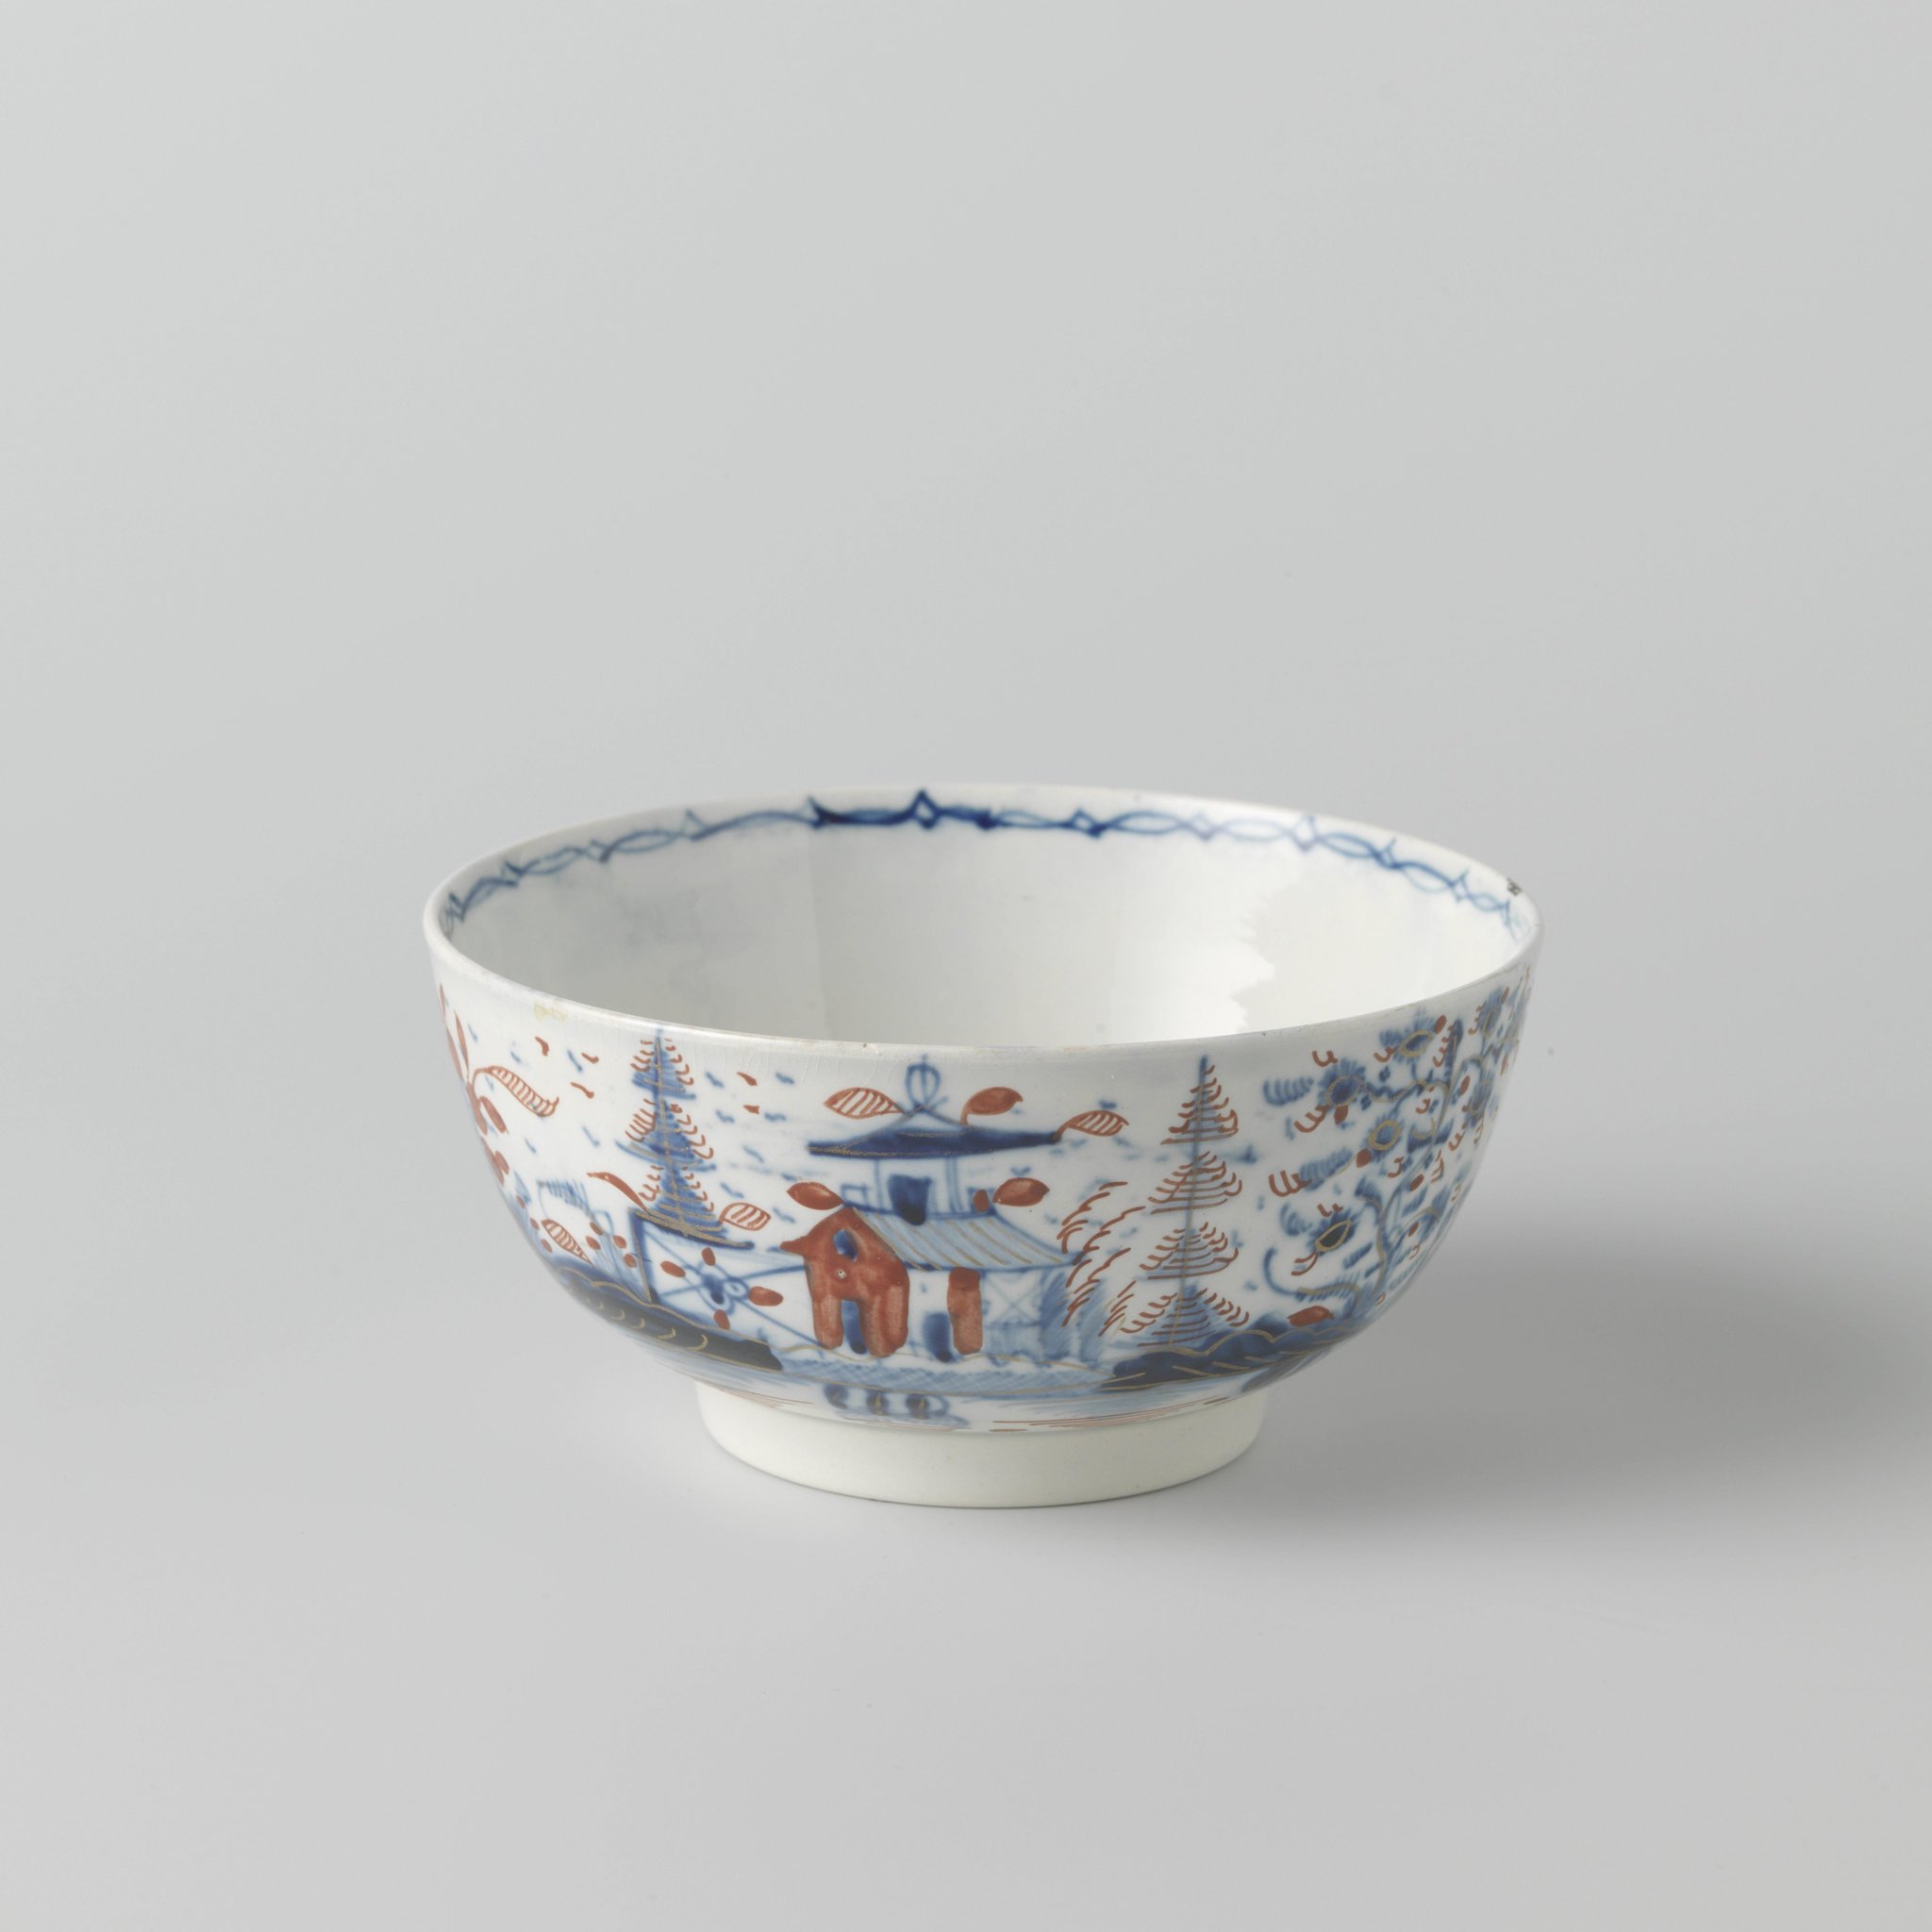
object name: slop bowl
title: Spoelkom van hardgebakken aardewerk; Leeds creamware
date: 1770-1790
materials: earthenware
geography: leeds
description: Halfbolvormige spoelkom van hardgebakken aardewerk, met een blauwe decoratie onder de glazuur en een veelkleurige decoratie op de glazuur. De decoratie doet Japans aan en bestaat uit een landschap waarin gestileerde bomen, planten en huizen. De kom staat op een standring